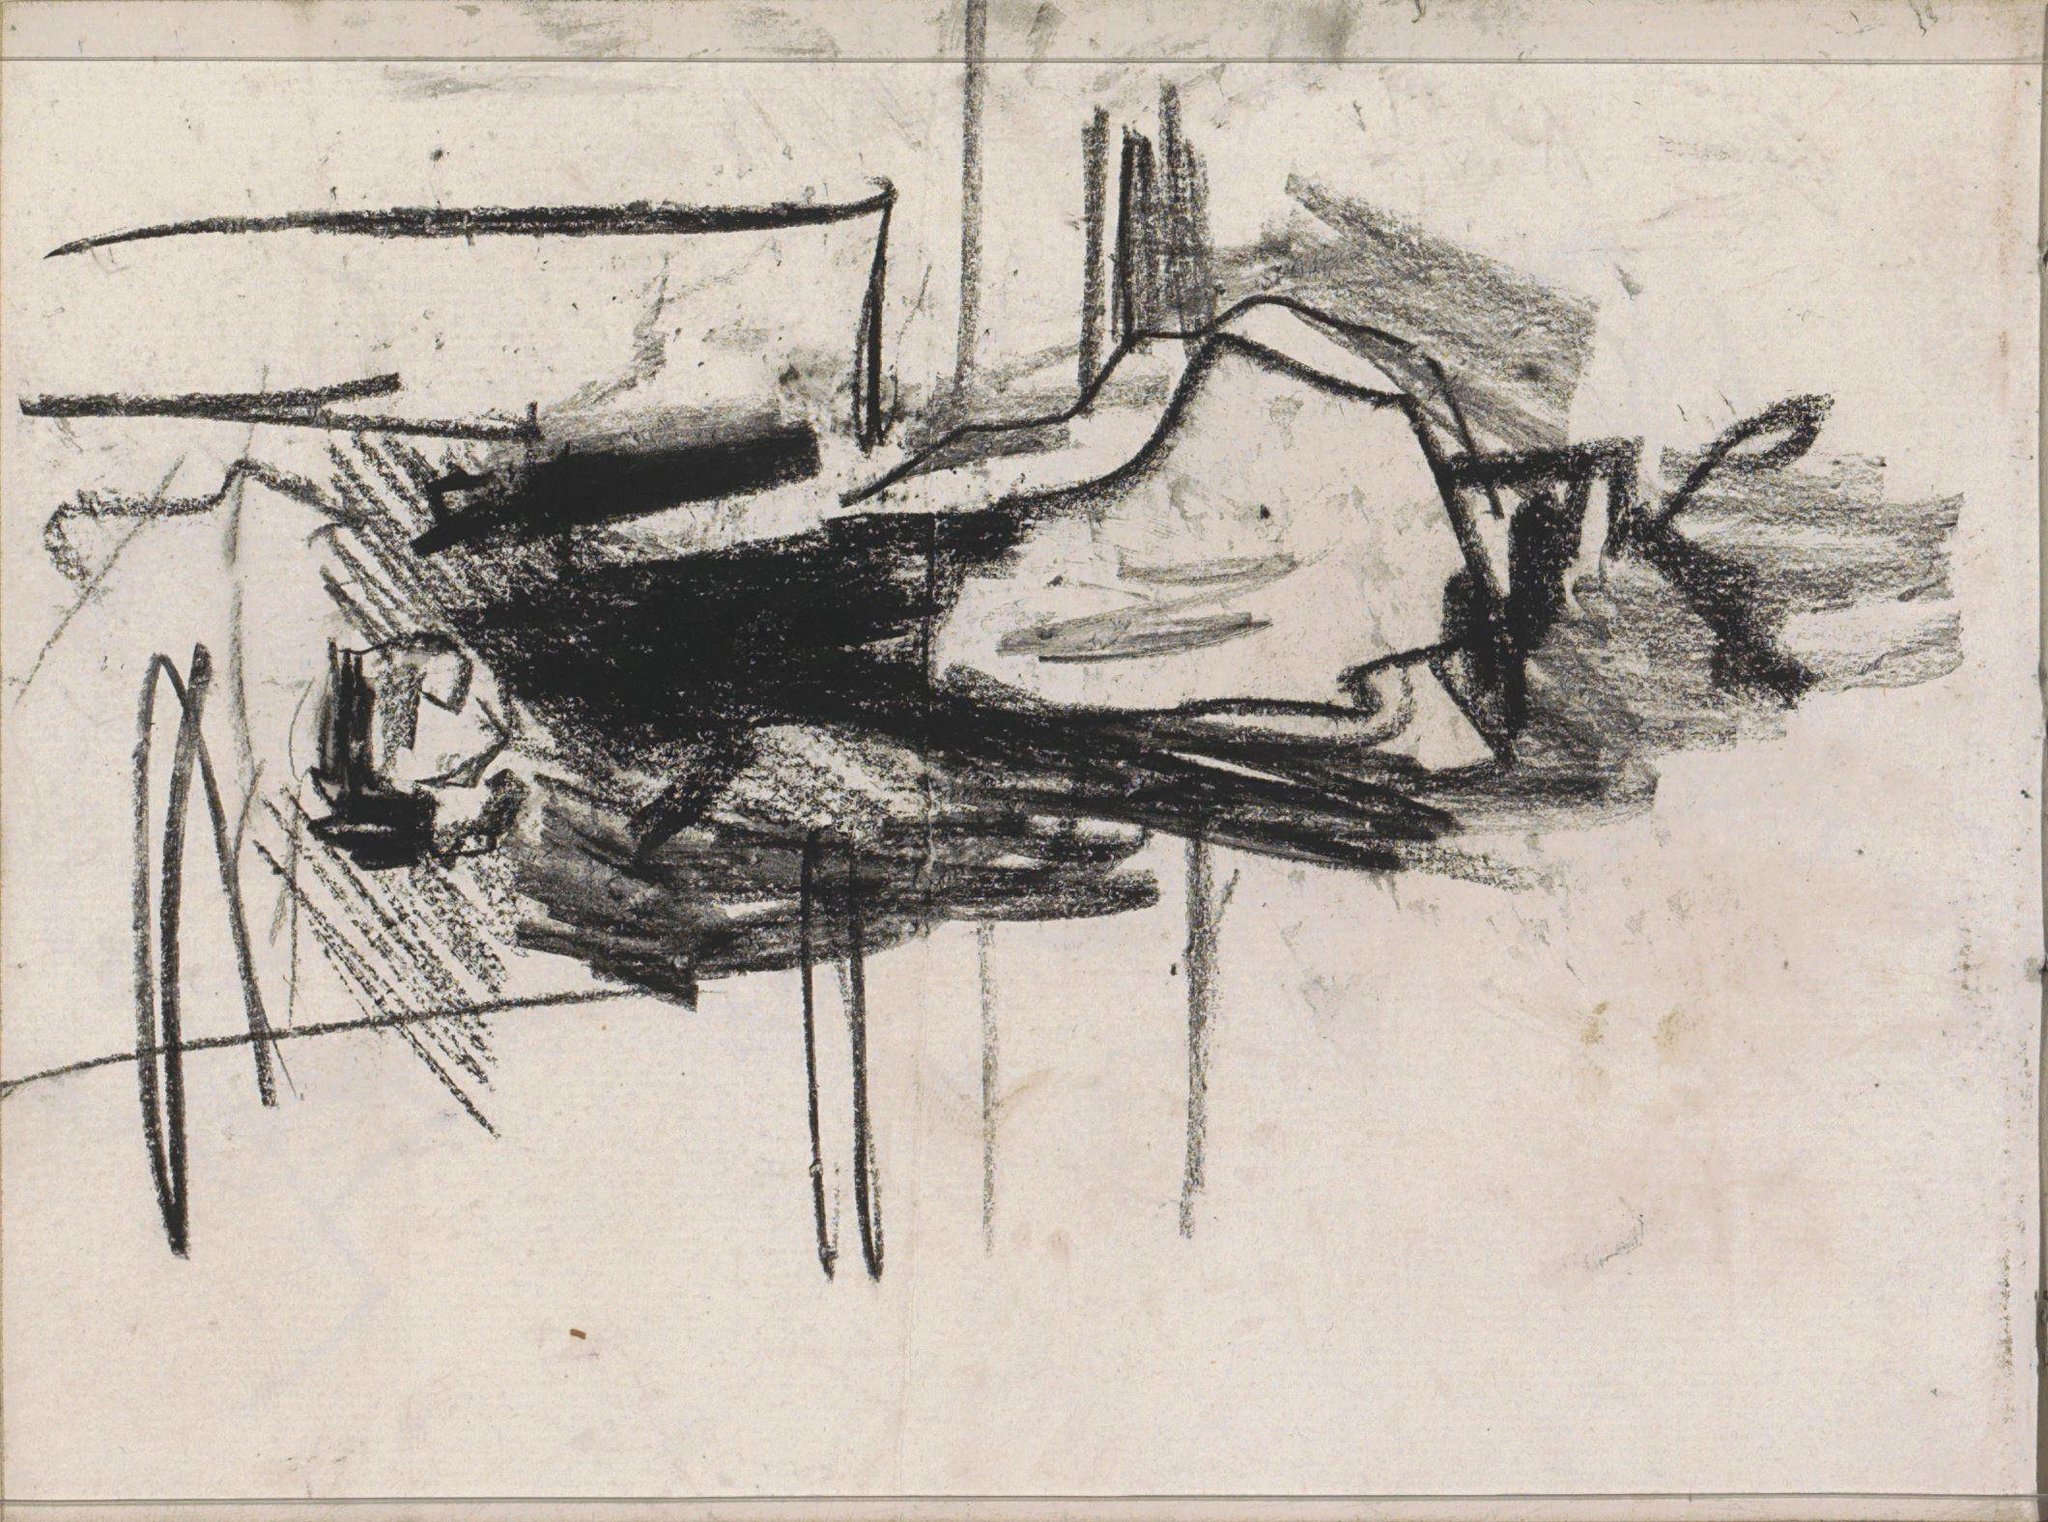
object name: sketchbook leaf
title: Twee vrouwen op straat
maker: isaac israels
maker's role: draughtsman, painter, print maker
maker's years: 1865-1934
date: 1875-1934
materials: chalk, paper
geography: the hague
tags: adult woman (+ standing), street (+ city(-scape) with figures, staffage)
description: Pagina 18 uit schetsboek XLI met 38 pagina's.